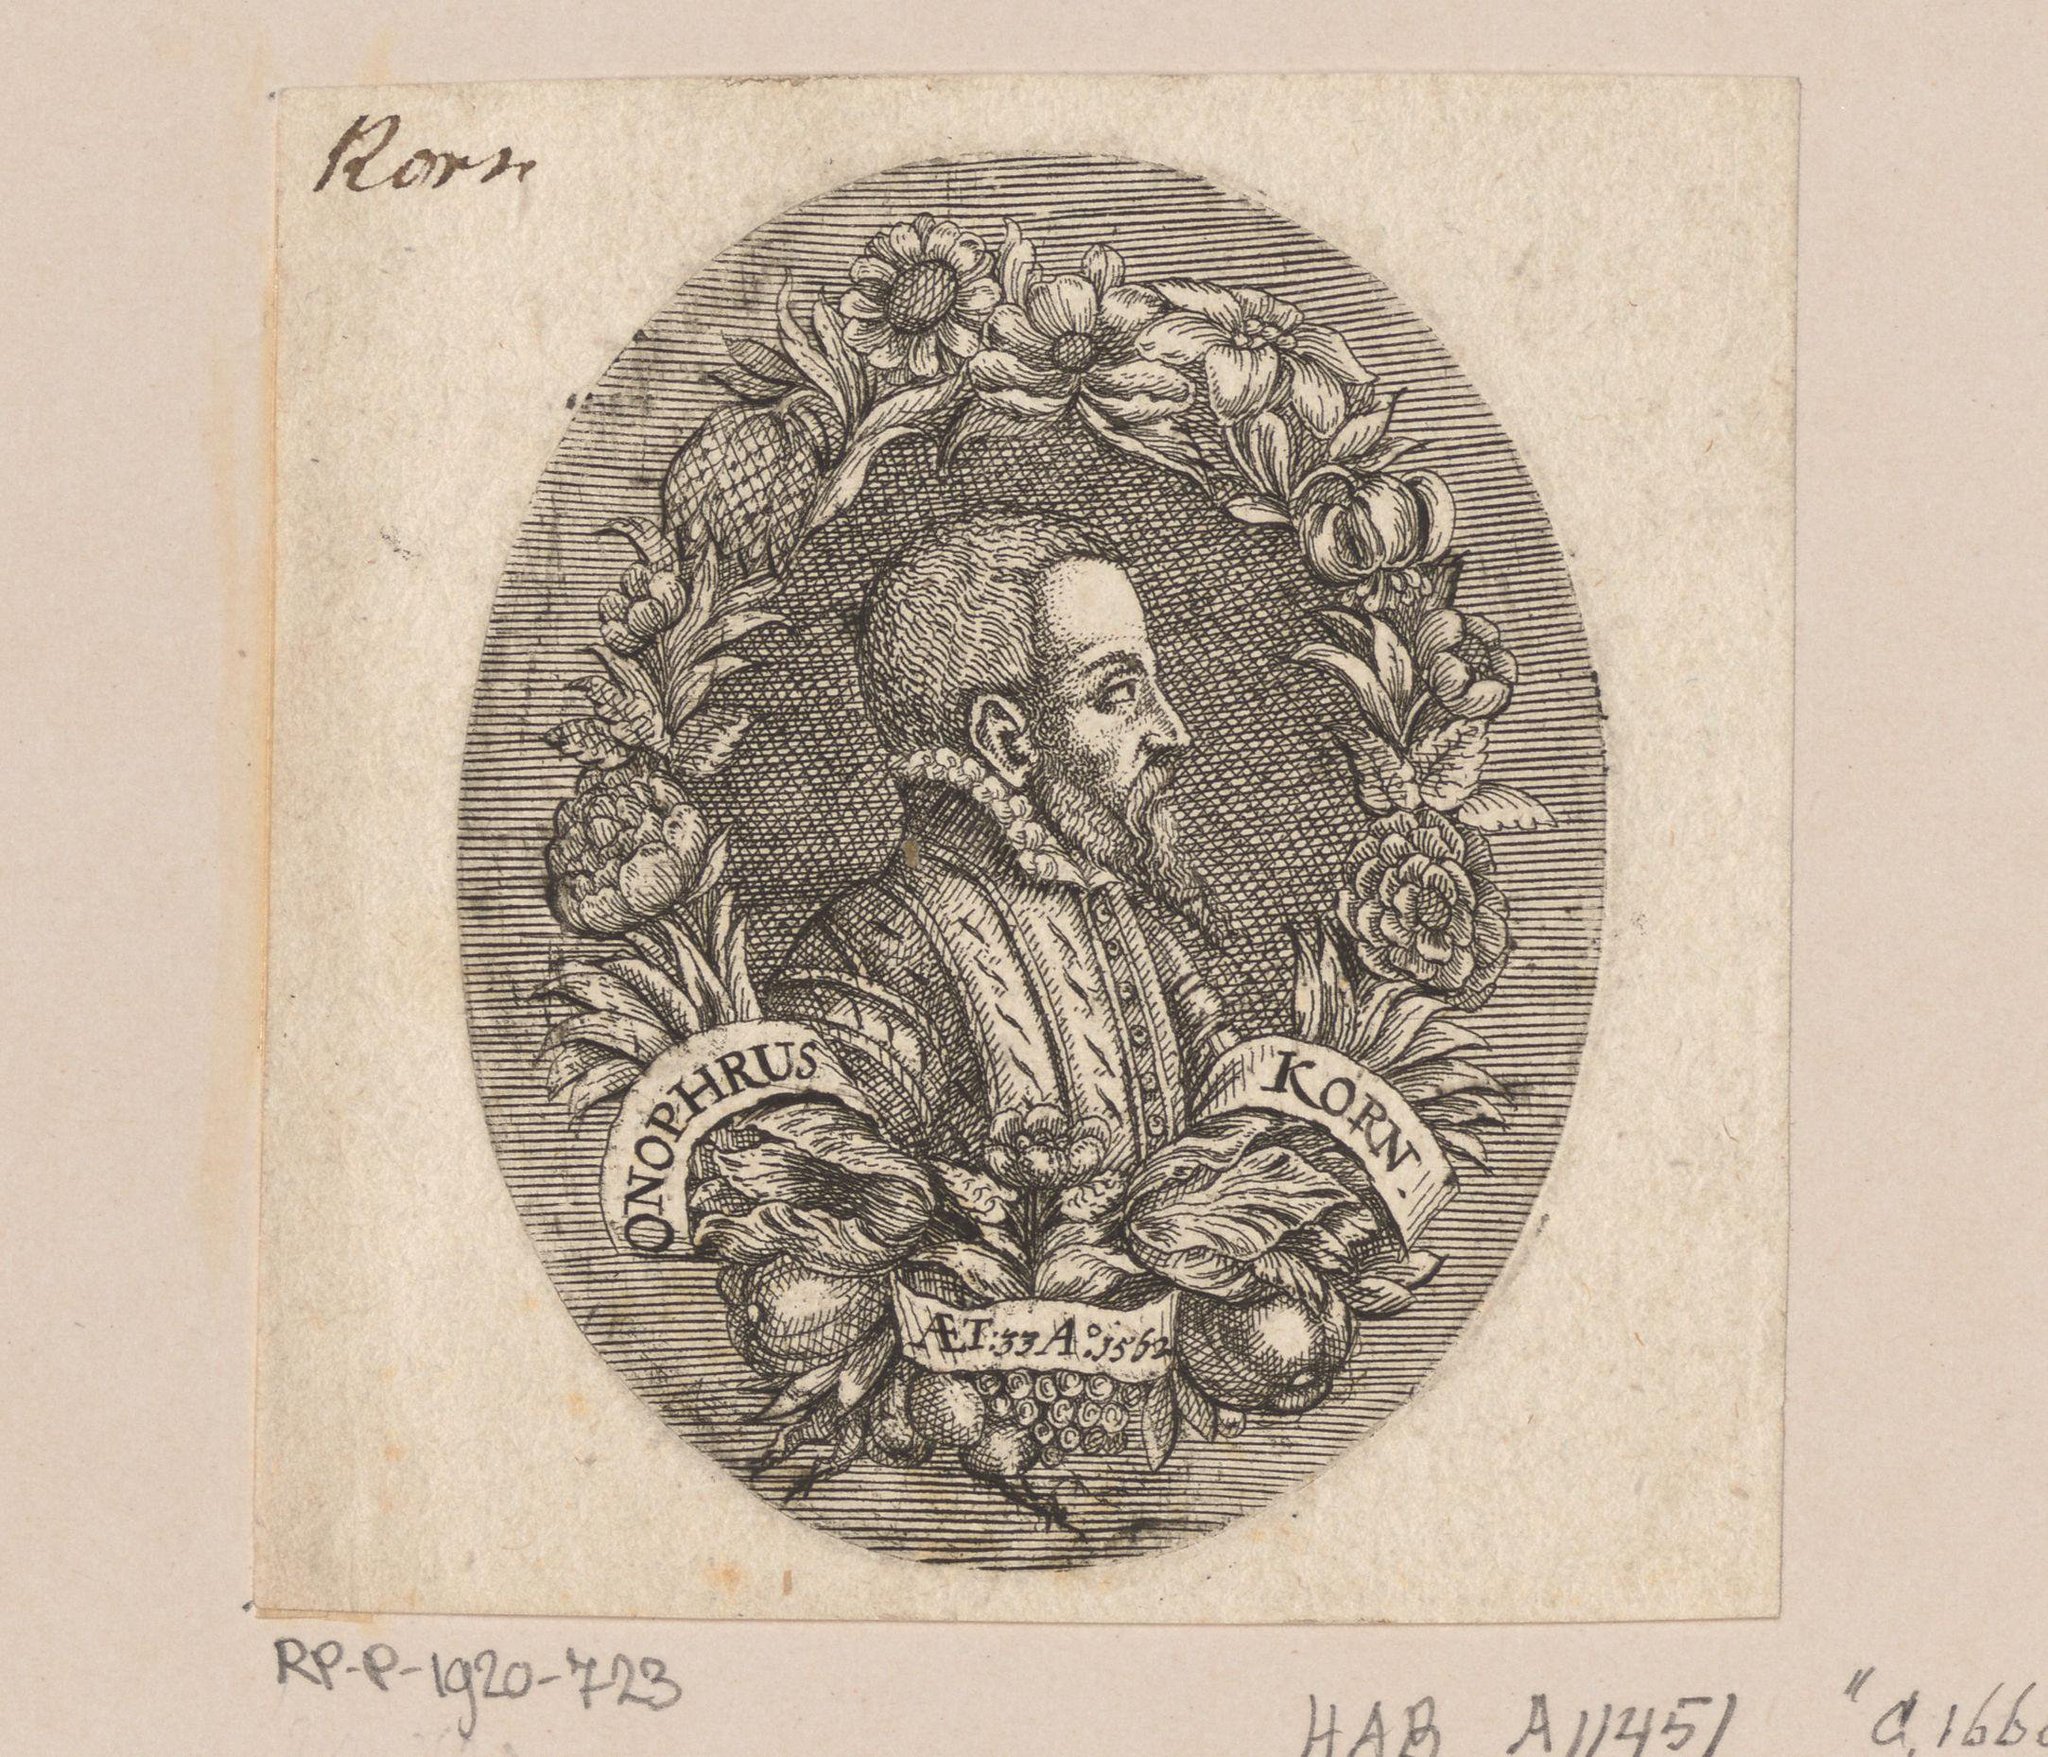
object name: print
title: Portret van Onophrius Korn op 33-jarige leeftijd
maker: Anonymous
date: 1600-1699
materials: paper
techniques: etching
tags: historical persons